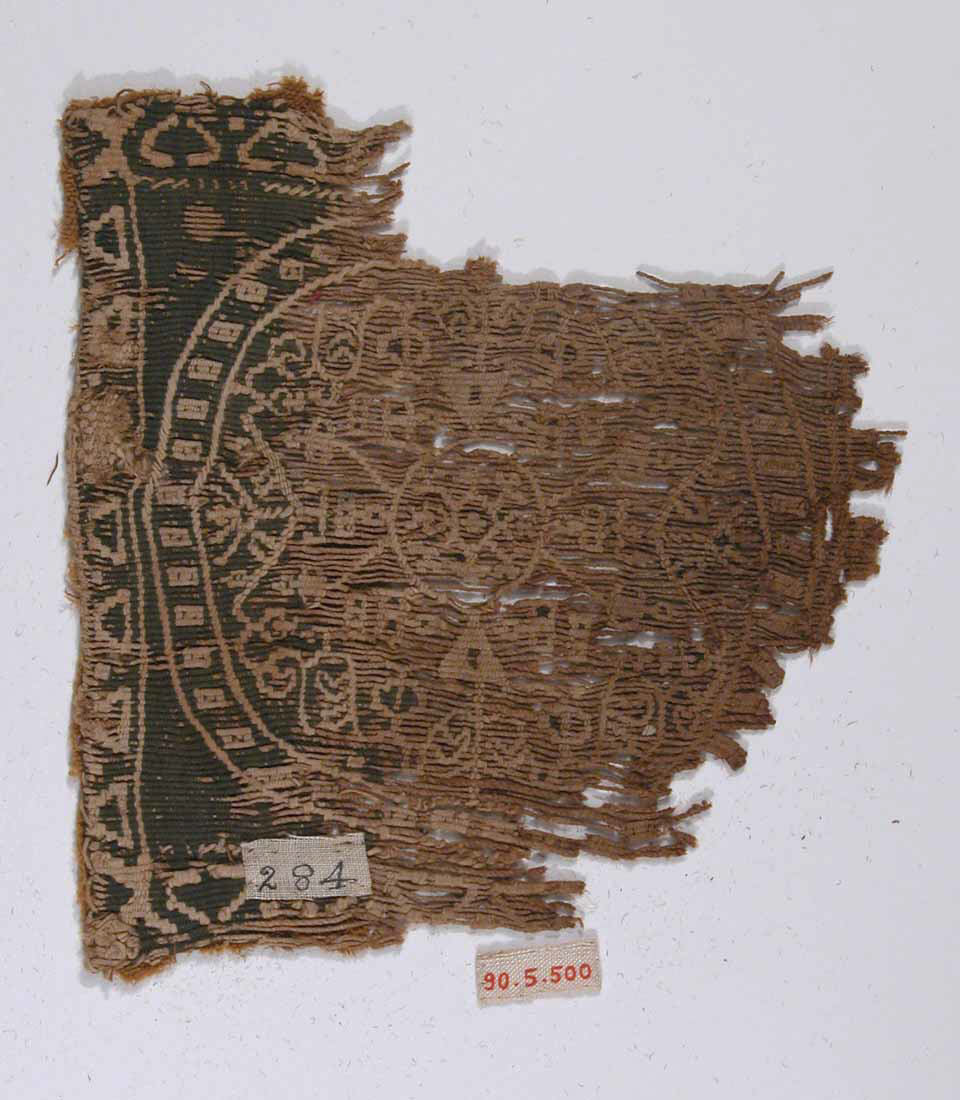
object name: textile fragment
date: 301-500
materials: linen, wool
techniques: weave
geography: egypt